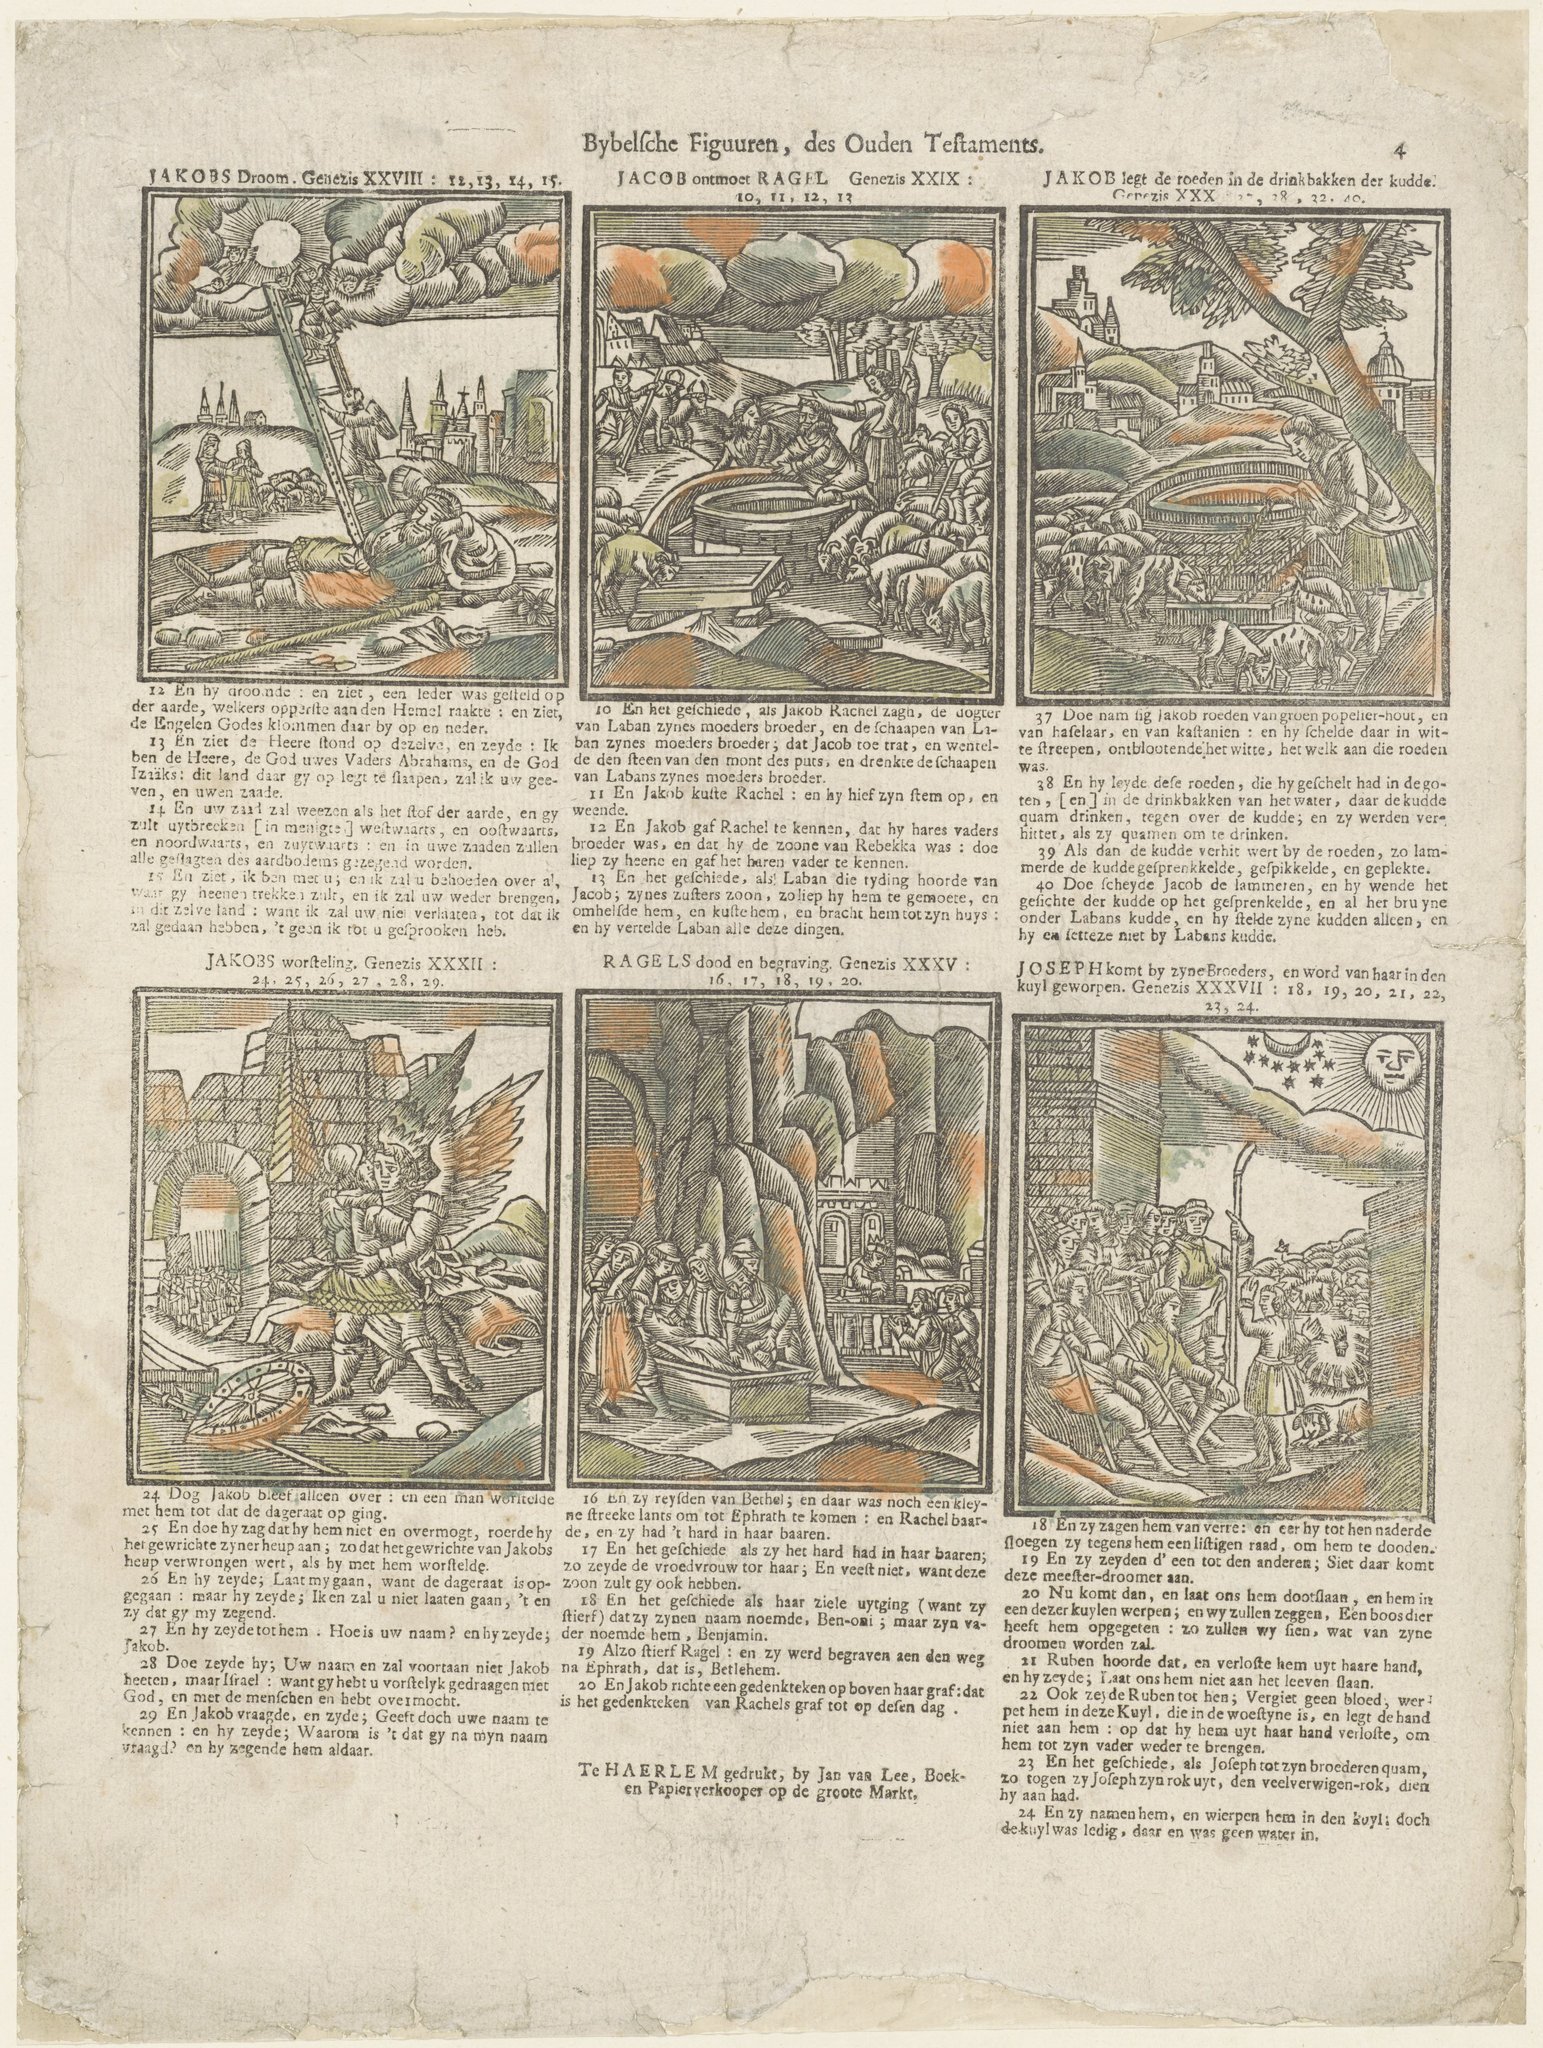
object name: print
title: Bybelsche figuuren, des Ouden Testaments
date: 1739-1786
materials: paper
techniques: colour, letterpress printing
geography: haarlem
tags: death of rachel (genesis 35:16-21), story of jacob, old testament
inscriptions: collector's mark: Lugt 2760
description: Blad met 6 voorstellingen uit het Oude Testament, waaronder Jakobs droom en de begrafenis van Rachel. Onder elke afbeelding een onderschrift en boven elke afbeelding een titel en Bijbelverwijzing. Genummerd rechtsboven: 4.